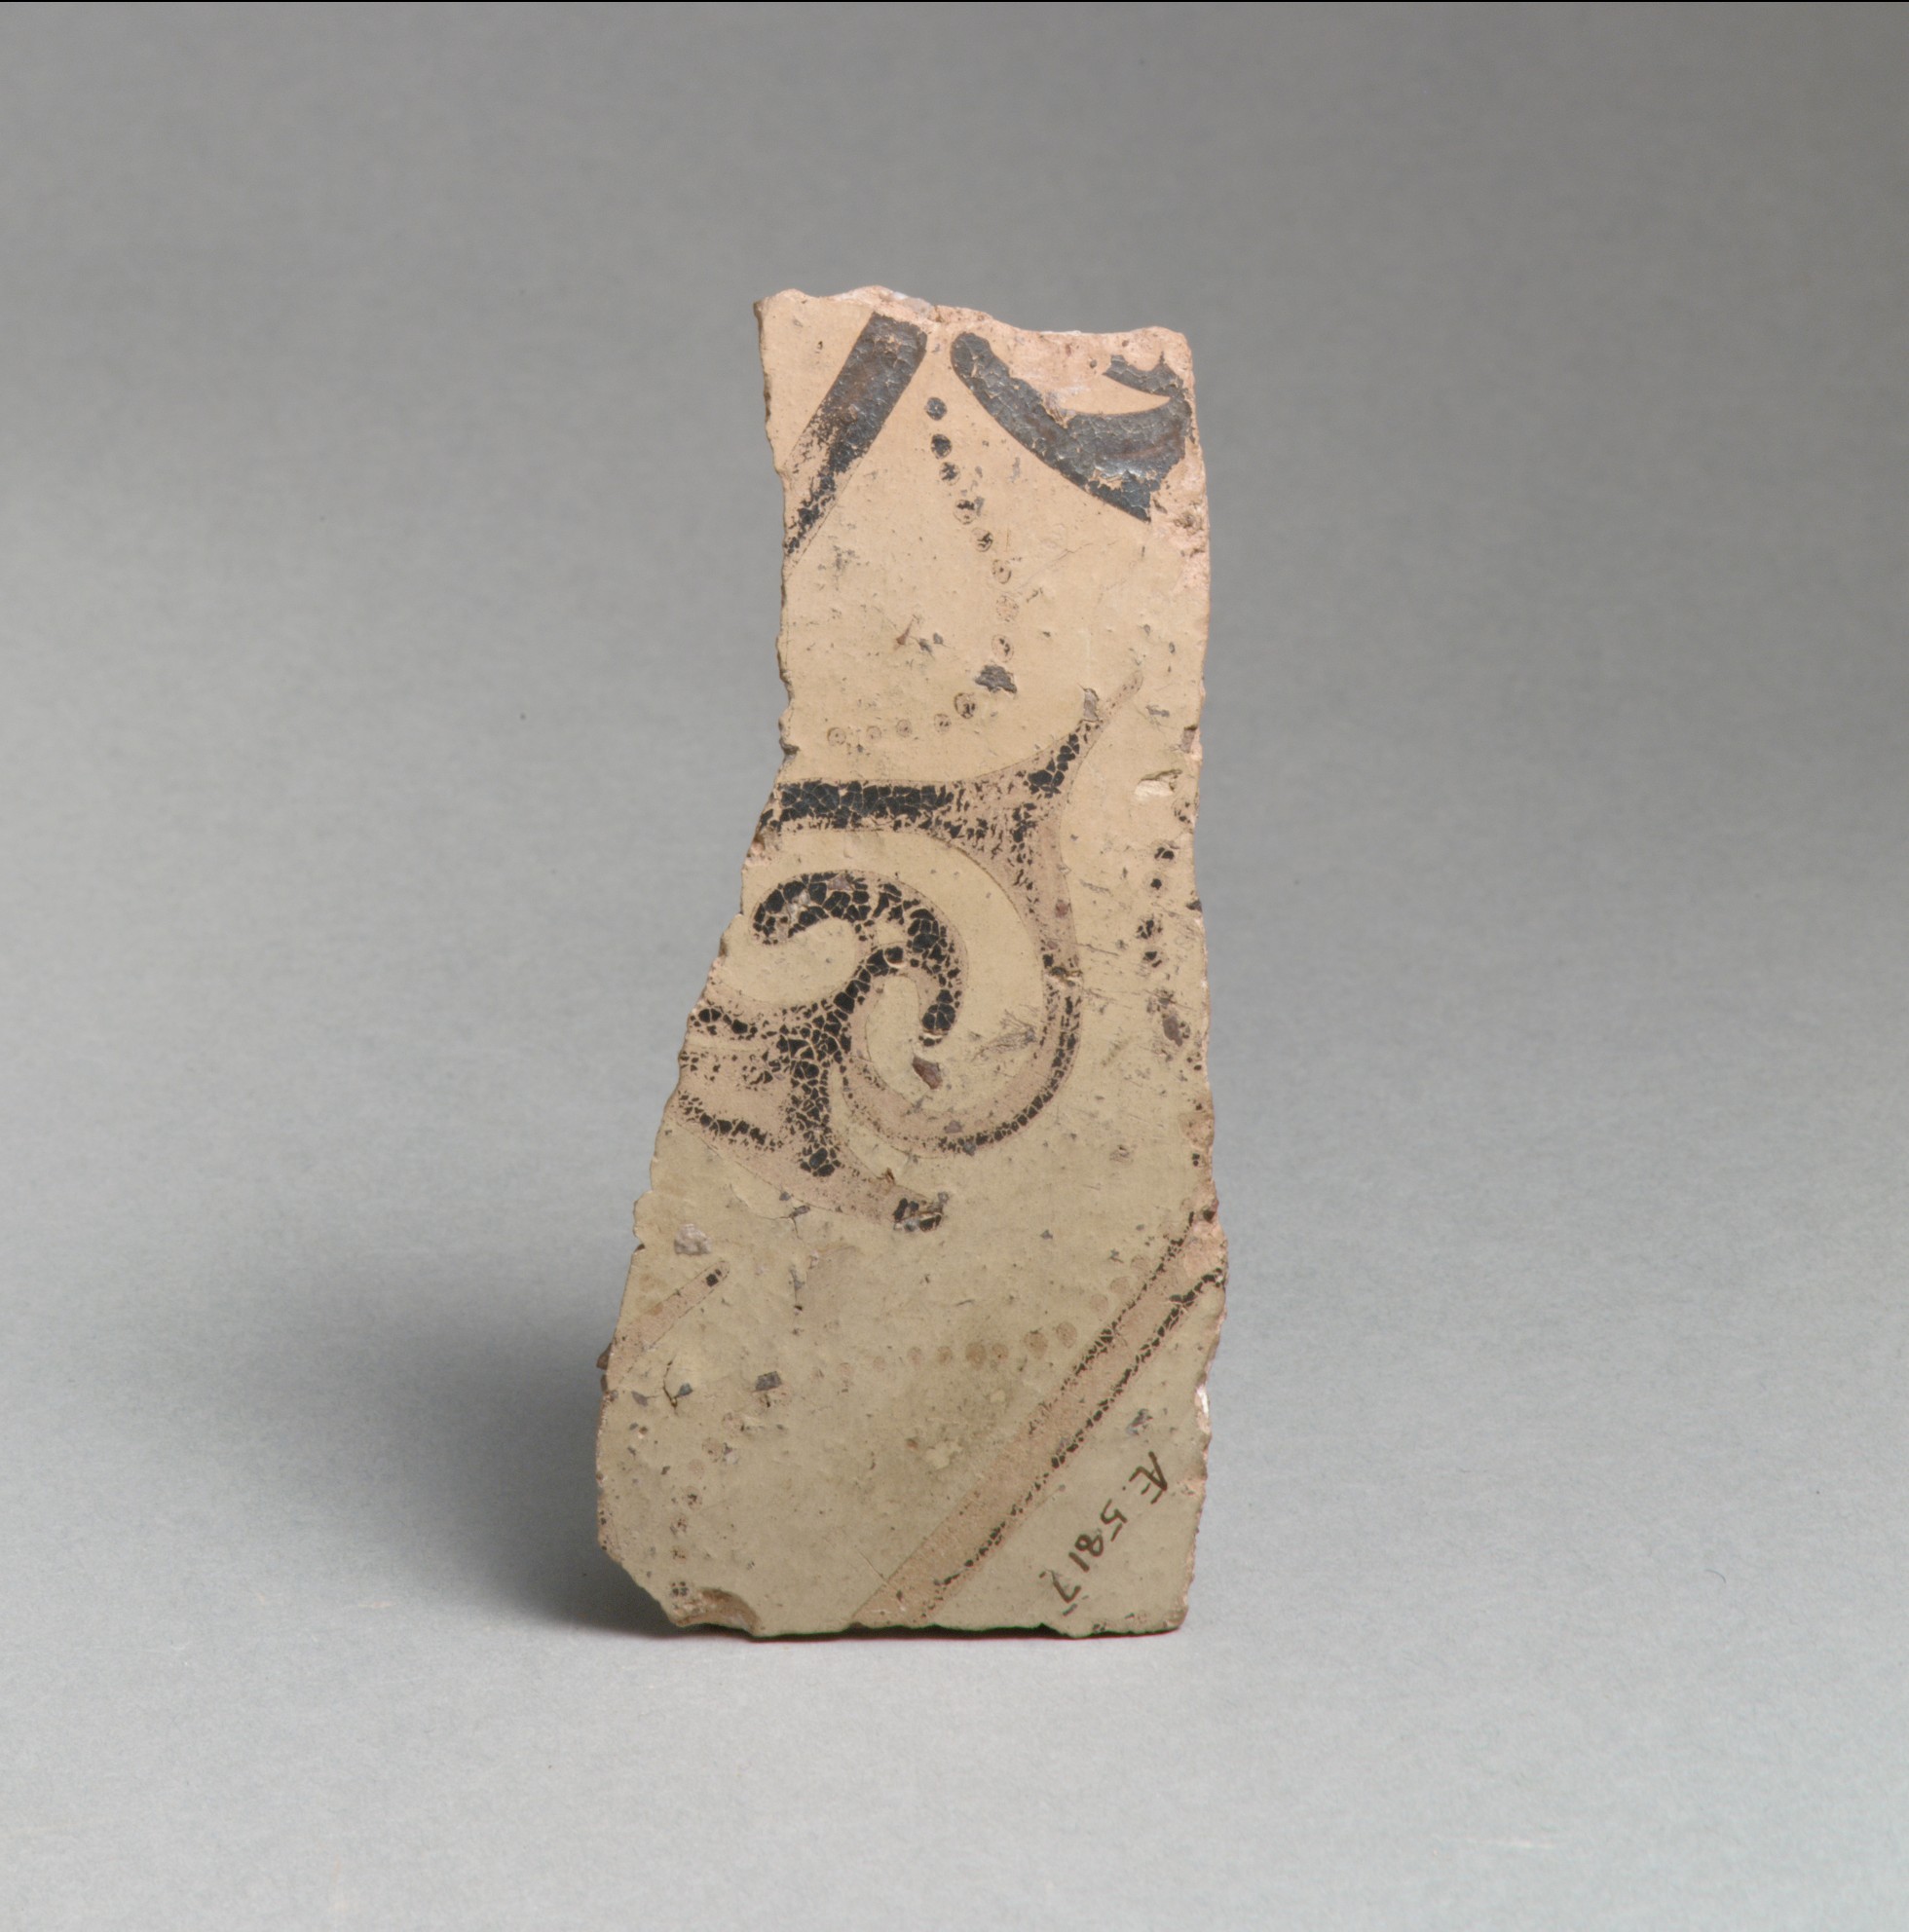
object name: vase fragment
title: Terracotta vessel fragment with ivy pattern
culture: minoan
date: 1525-1450 BCE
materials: terracotta